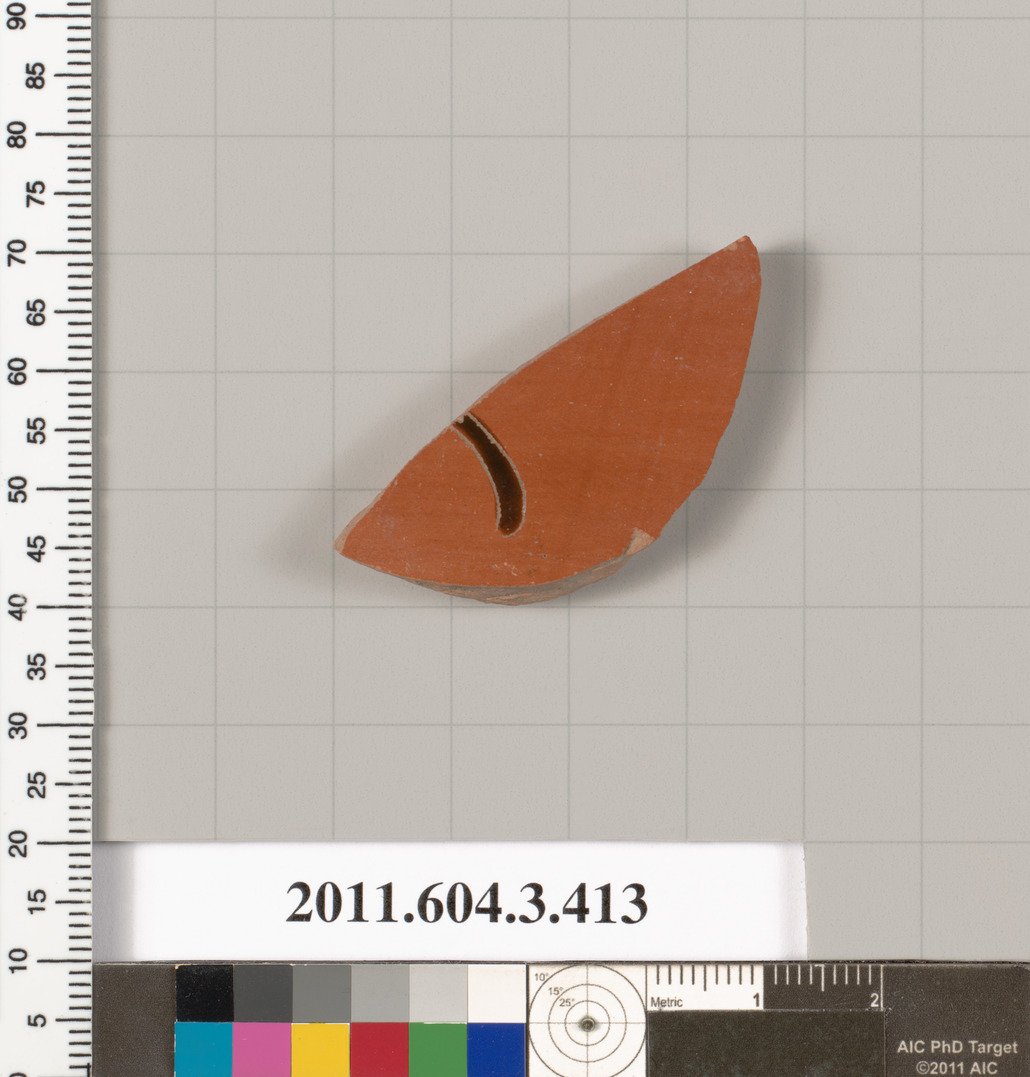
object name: neck amphora fragment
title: Terracotta fragment of a neck-amphora (jar)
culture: greek, attic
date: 500-468 BCE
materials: terracotta